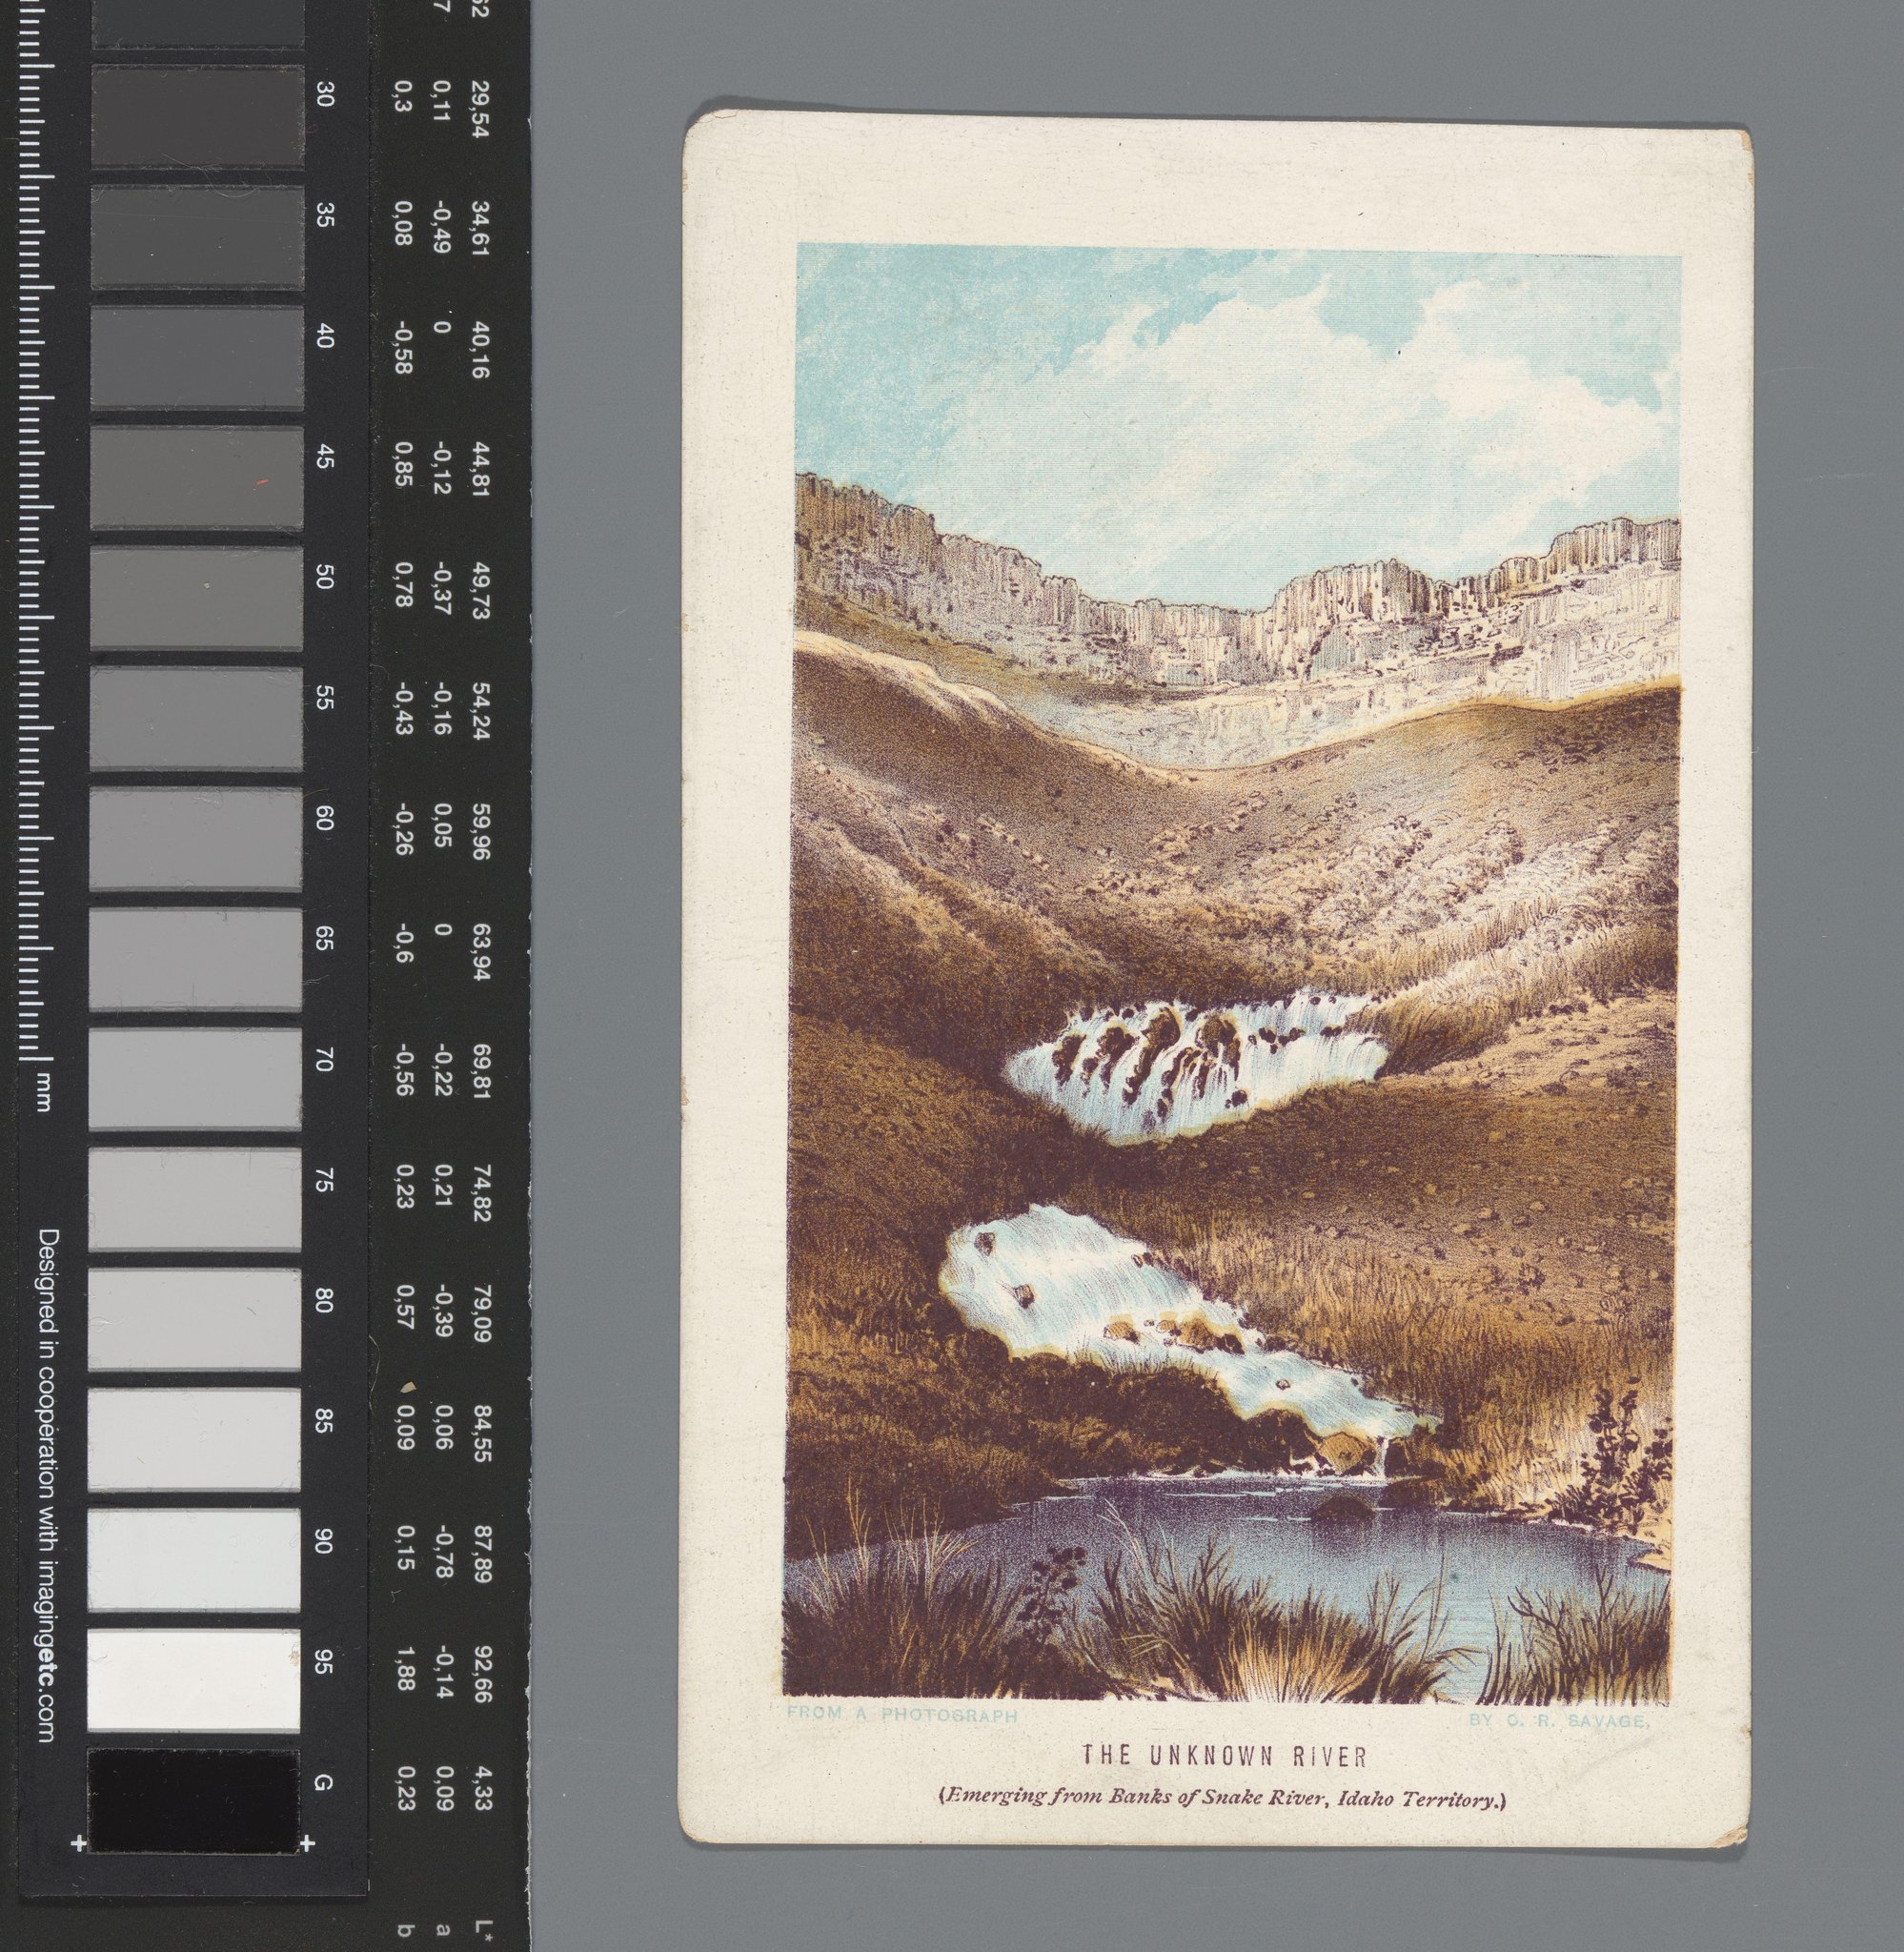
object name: print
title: Watervallen in Idaho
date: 1870-1875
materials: paper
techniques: lithograph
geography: edinburgh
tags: river, waterfall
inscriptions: inscription: ‘From a photograph by C.R. Savage.’, inscription: ‘(Emerging from Banks of Snake River, Idaho Territory.)’